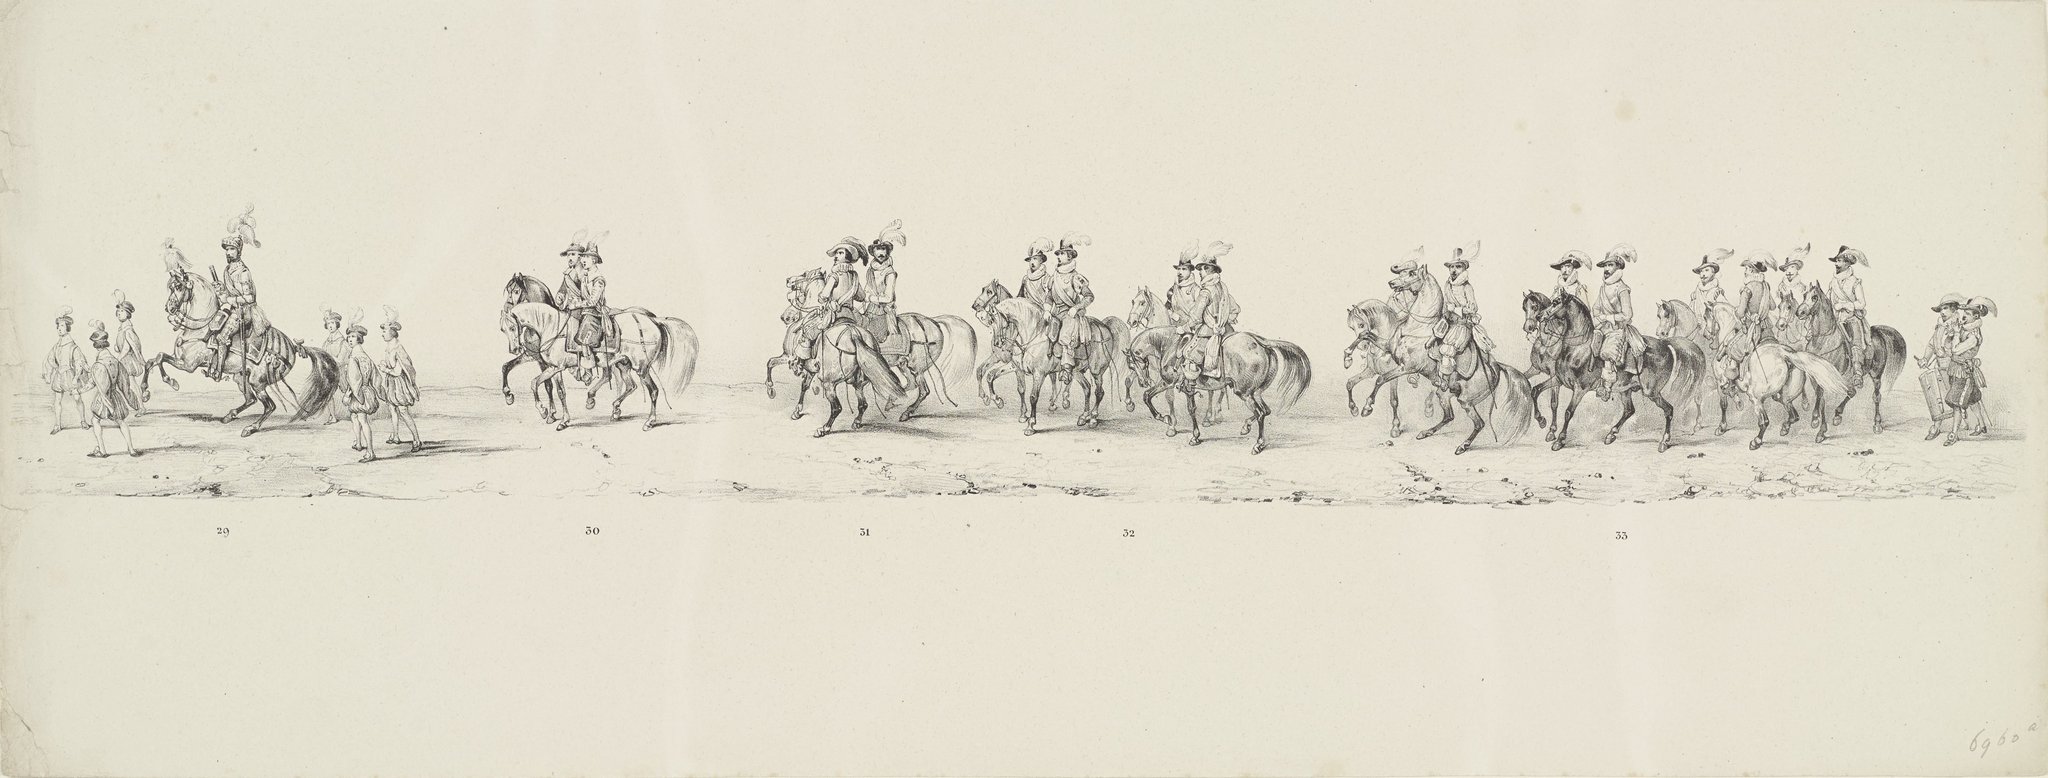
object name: print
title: Historische optocht bij het tweede eeuwfeest van de Utrechtse Hogeschool, 1836 (plaat 8)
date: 1836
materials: paper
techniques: lithograph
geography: paris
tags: students' pageant, costumes used in pageants, battle of nieuwpoort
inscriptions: collector's mark: Lugt 2228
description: Historische gekostumeerde optocht van de studenten van de Hogeschool van Utrecht op 16 juni 1836, bij de viering van het tweede eeuwfeest van de Utrechtse Hogeschool. De optocht verbeeldt de intocht van het Staatse leger in Oostende op 3 juli 1600, daags na de overwinning in de Slag bij Nieuwpoort. Achtste plaat in een serie van tien ongenummerde platen, met de groepen genummerd 29-33.